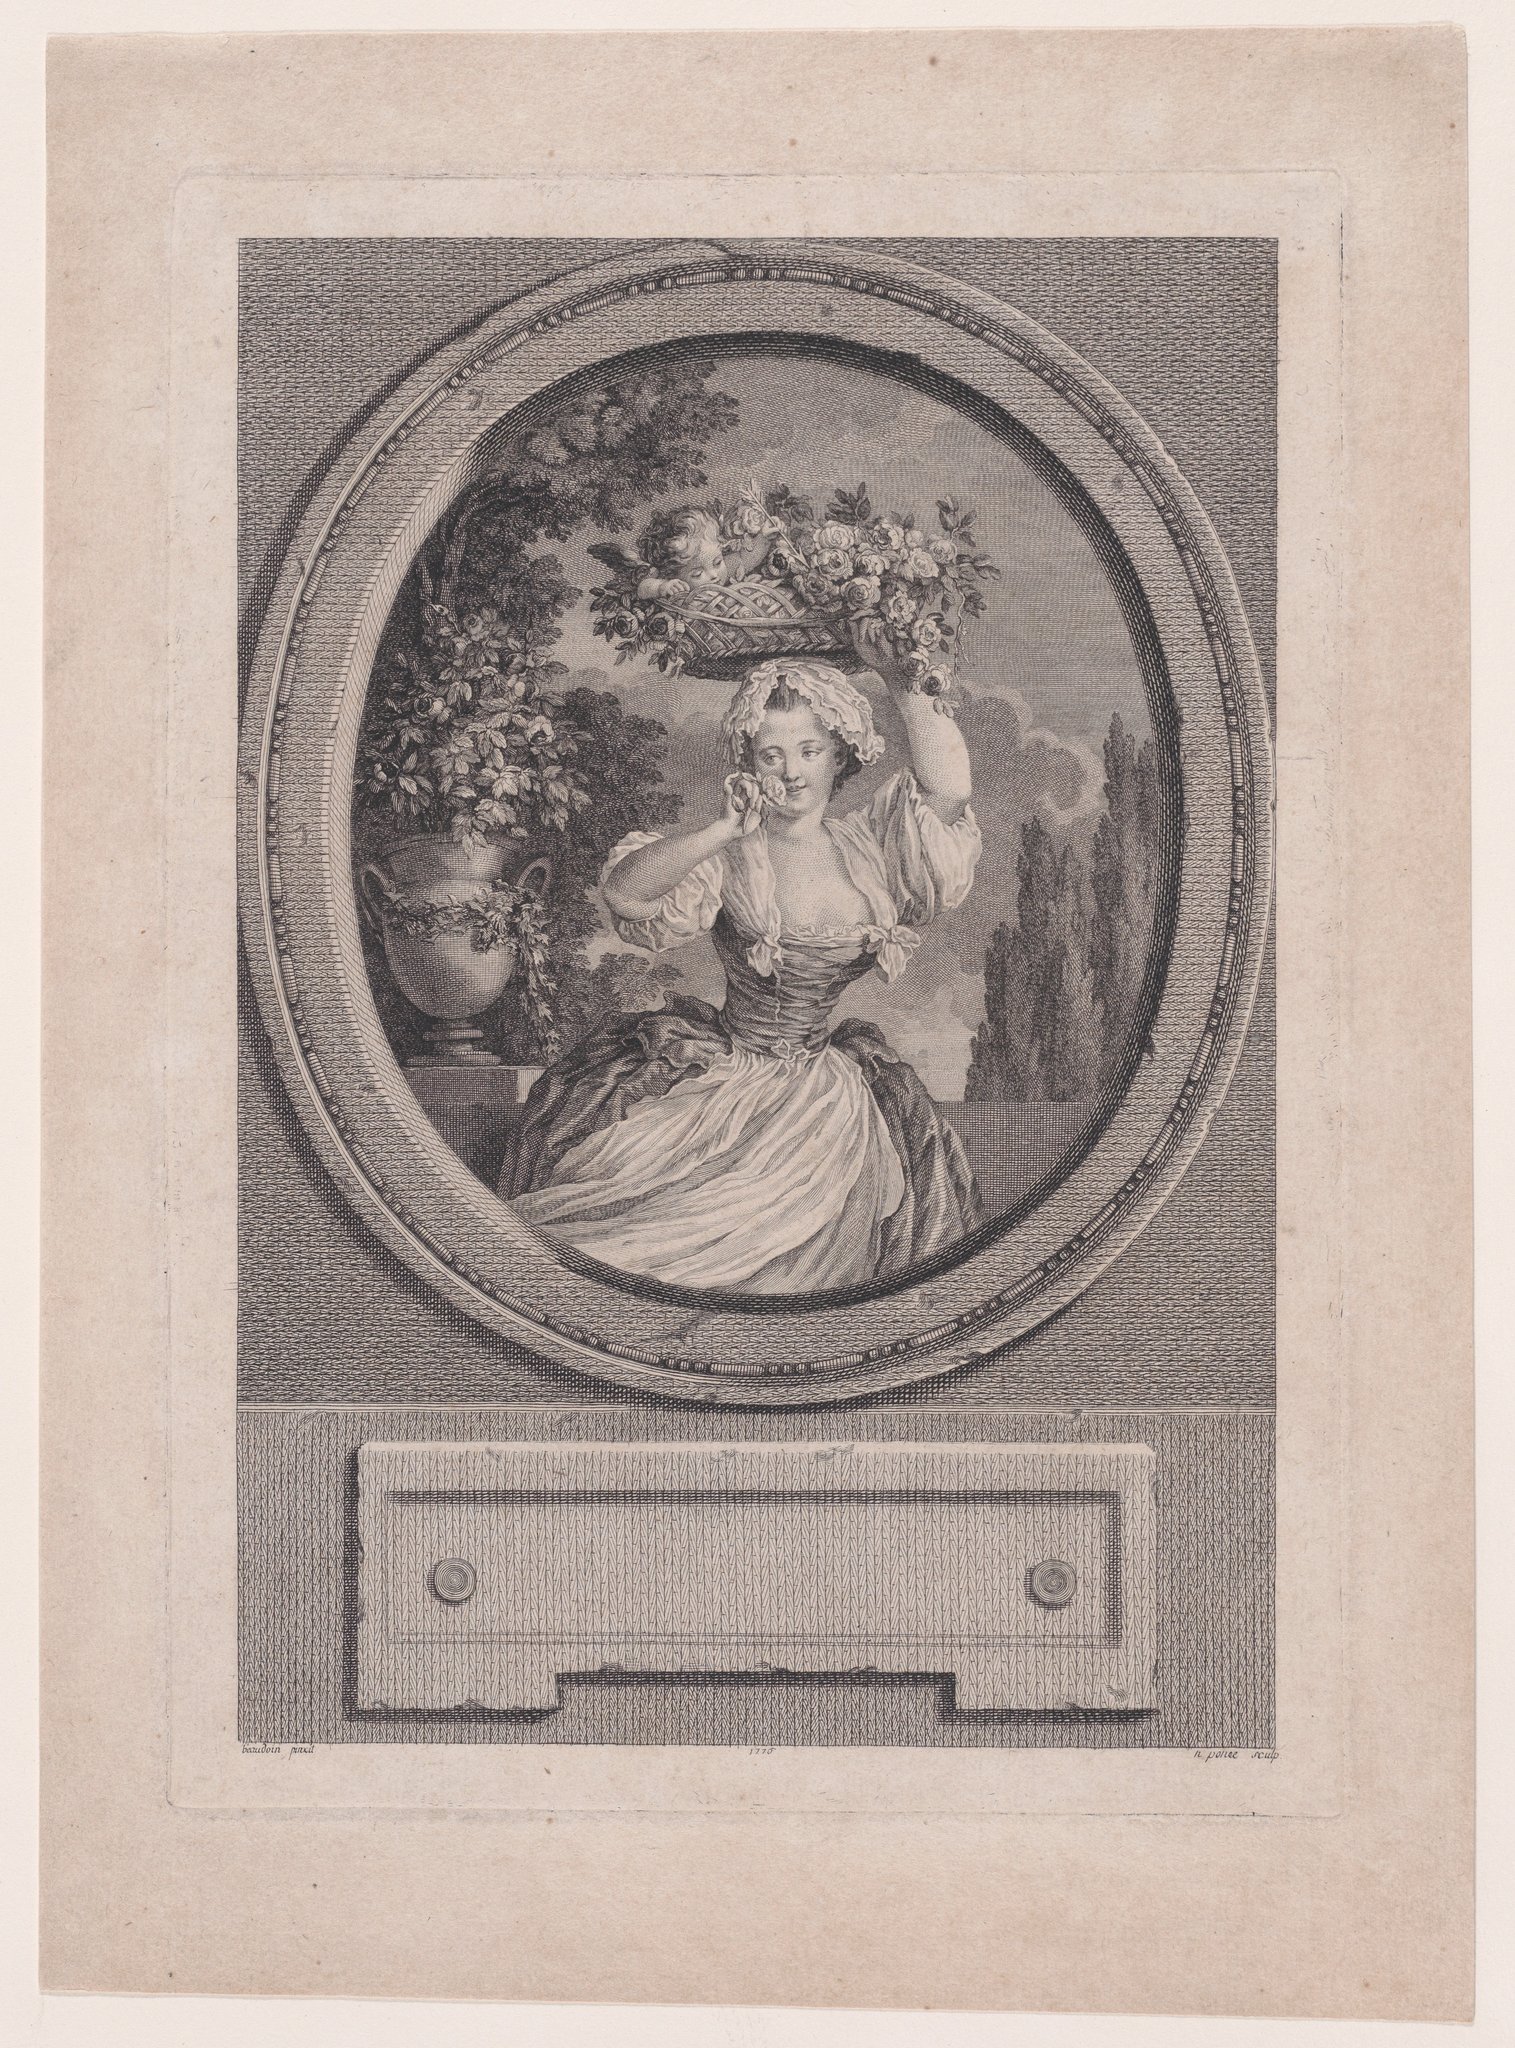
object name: print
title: Marton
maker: pierre antoine baudouin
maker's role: artist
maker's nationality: french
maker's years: 1723-1769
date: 1776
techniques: engraving